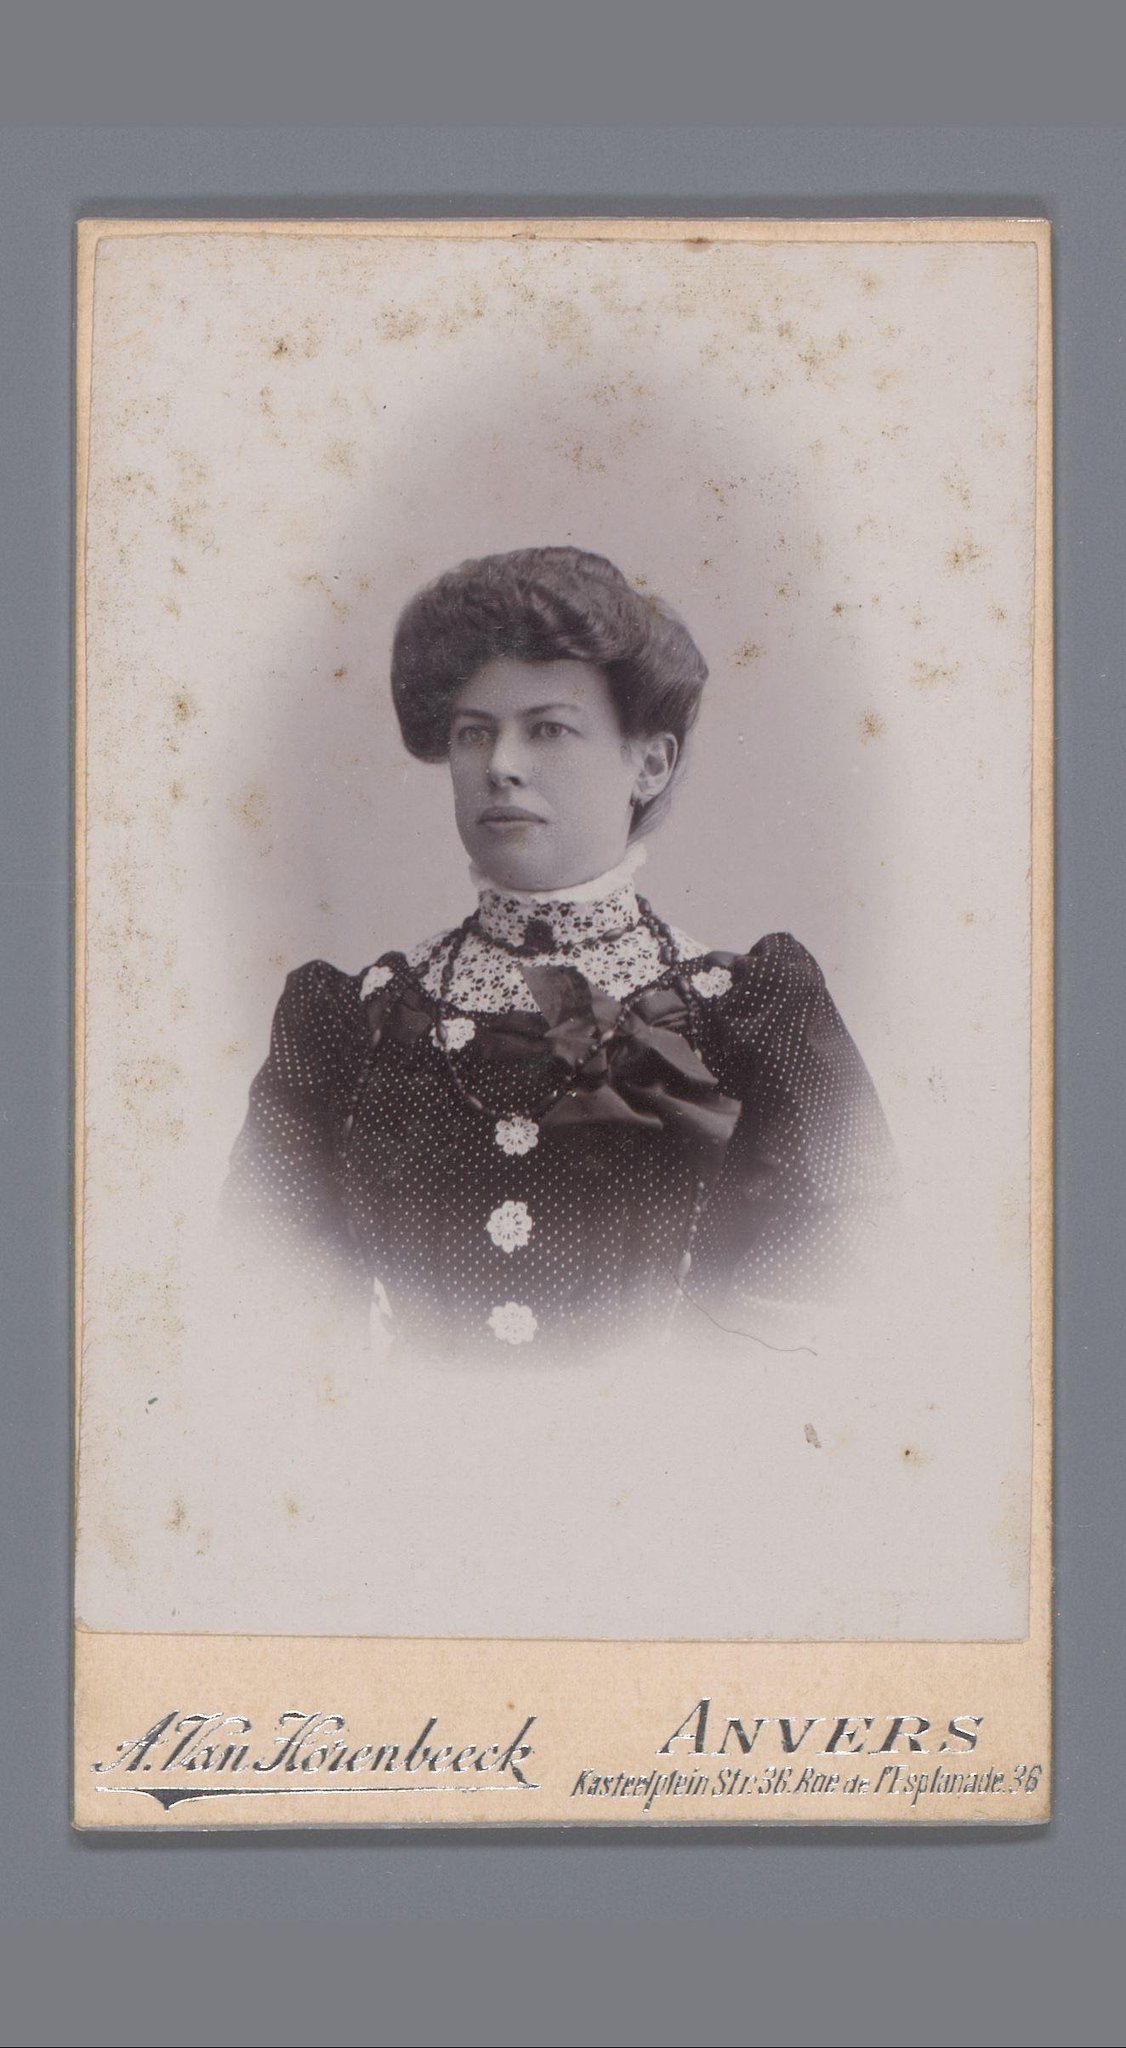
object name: photograph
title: Portret van een onbekende vrouw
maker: antoine van horenbeeck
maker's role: fotograaf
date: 1903-1913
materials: cardboard, photographic support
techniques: collodion silver print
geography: antwerp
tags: adult woman, historical persons - bb - woman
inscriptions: inscription: ‘MÉDAILLE D'OR/ ANVERS 1893/ MÉDAILLE D'OR/ ANVERS 1896/ A. Vn Horenbeeck/ Photographie/ Artistique/ KASTEELPLEIN STR. 36/ ANVERS/ Rue de l'Esplanade, 36/ J. AUDENAERDE GAND.’